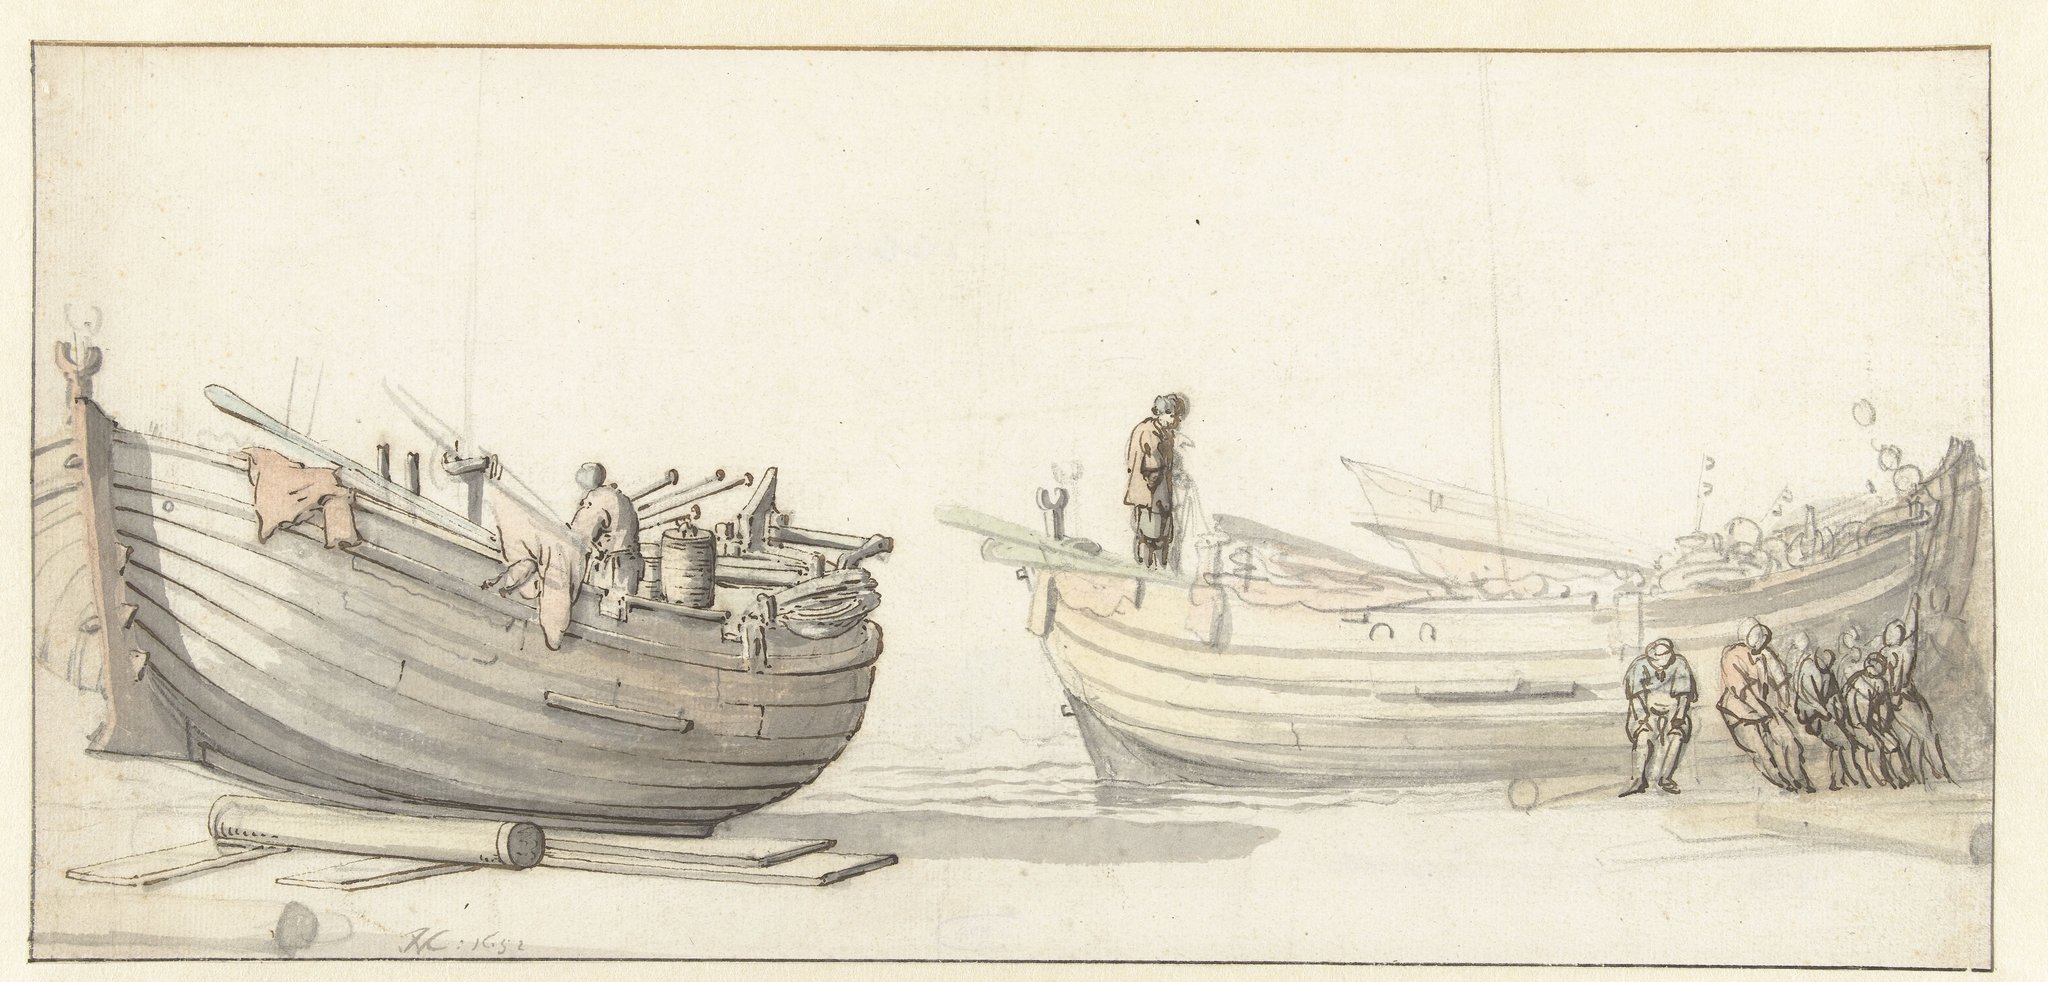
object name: drawing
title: Studie van twee vissersboten met figuren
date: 1652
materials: chalk, ink, paper, watercolor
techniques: brush, pen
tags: commercial fishery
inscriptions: date: ‘1652’